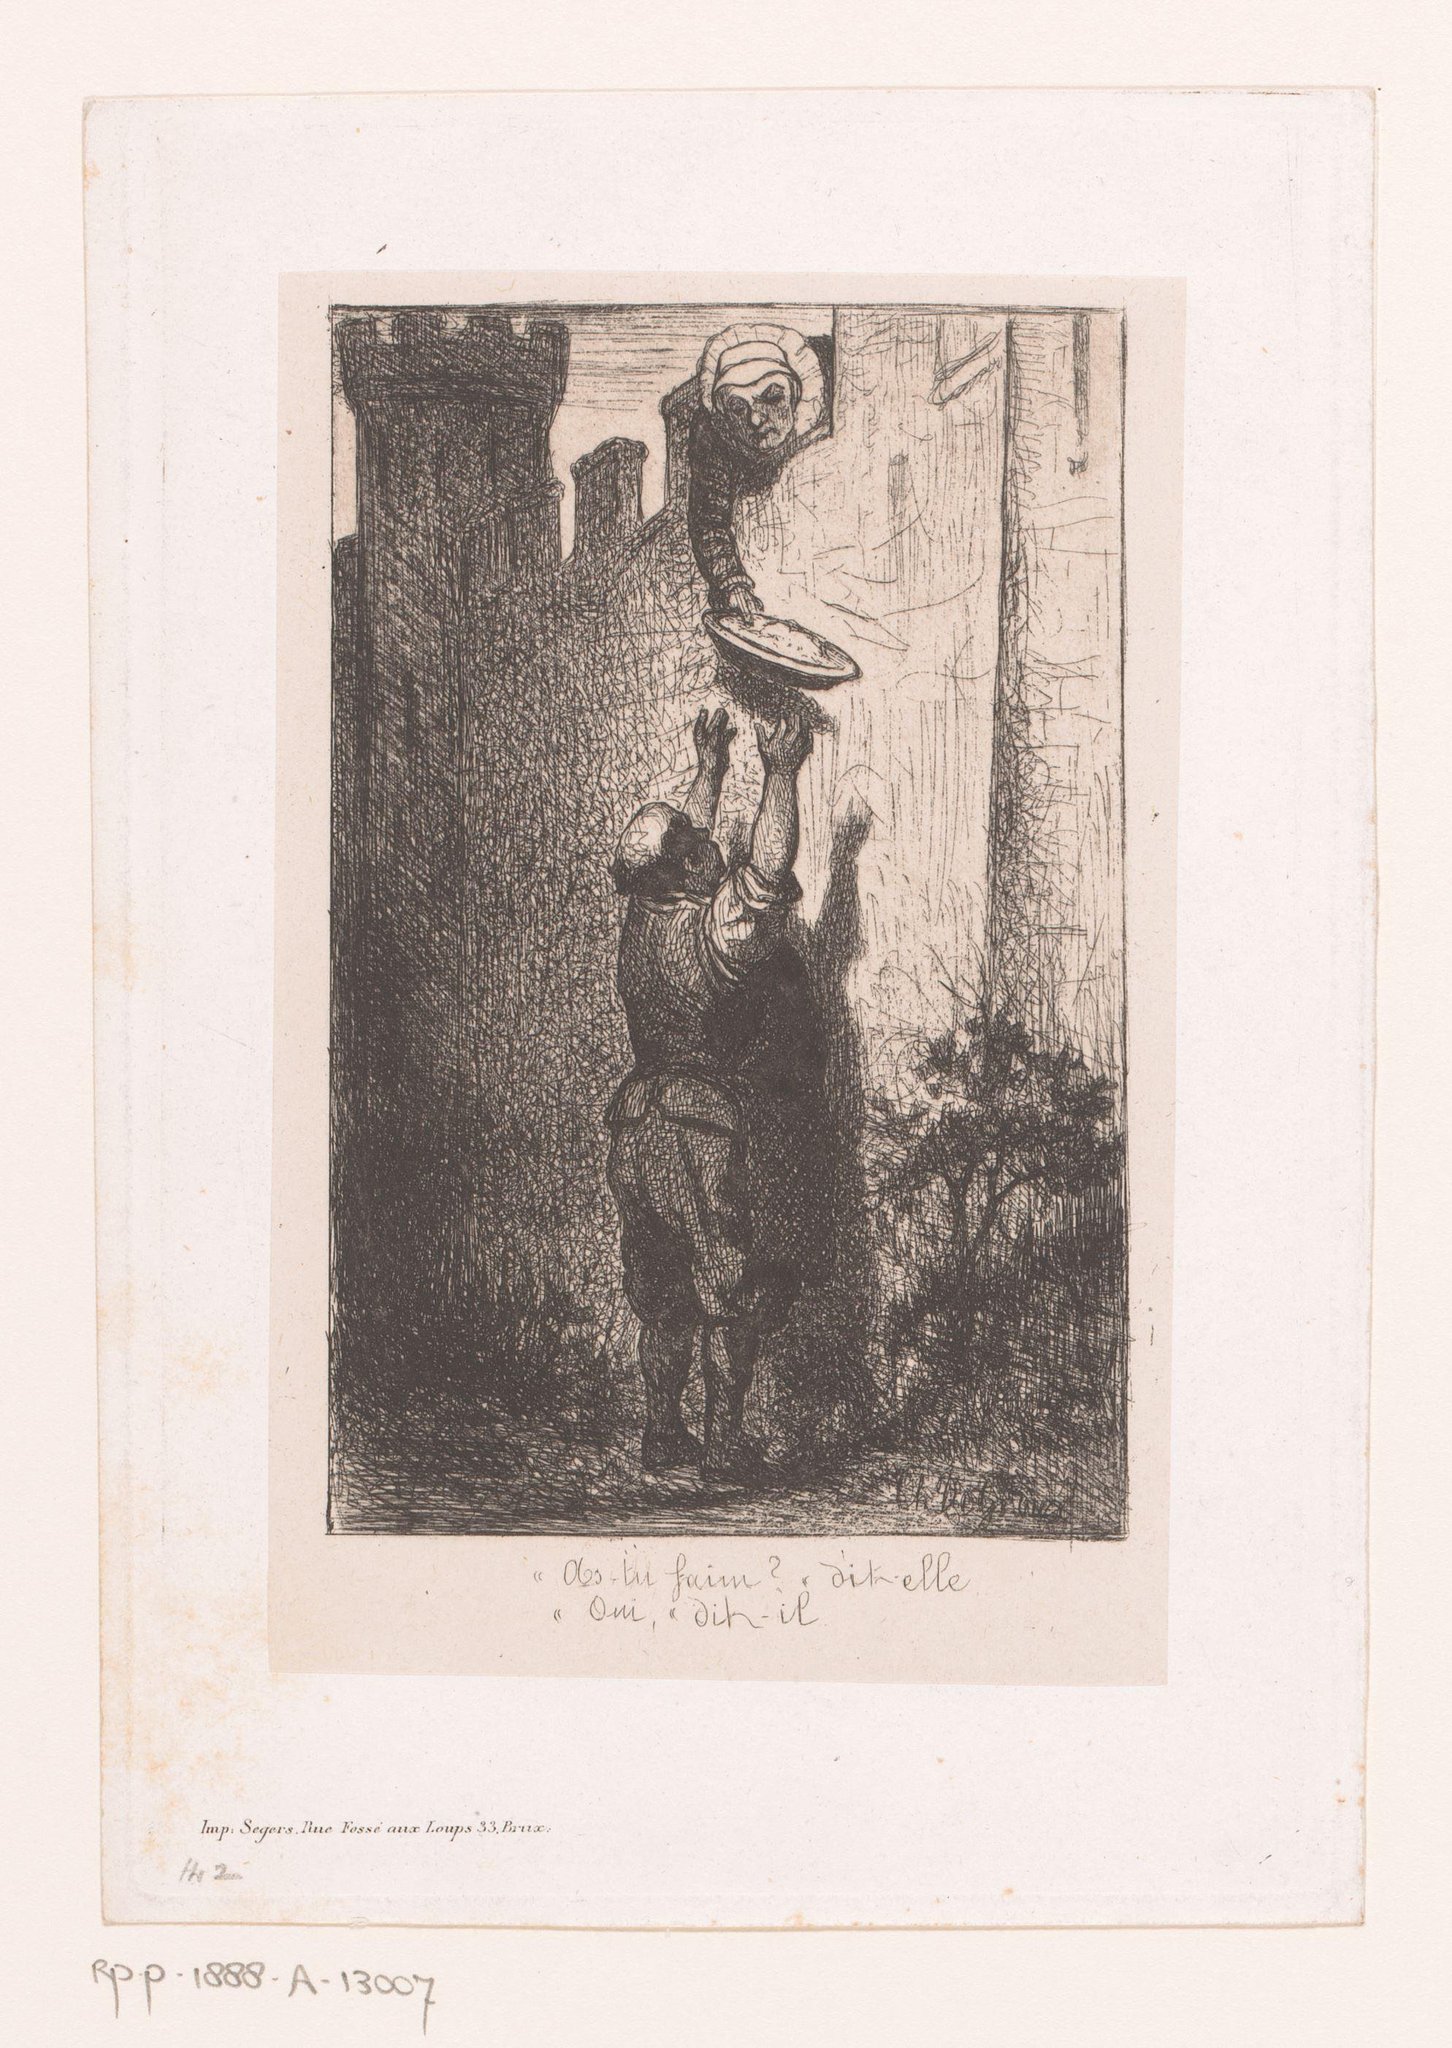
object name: book illustration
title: "As-tu faim?" dit-elle. "Oui," dit-il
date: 1861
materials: paper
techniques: etching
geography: brussels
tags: giving alms or other charity, e.g.: handing out food, battlement, crenellation ~ fortified city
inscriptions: collector's mark: Lugt 2228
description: Latere staat van deze prent gebruikt in: Coster, Charles de. Légendes Flamandes. 1e druk. Brussel: Veuve Parent & Fils, Parijs: Michel-Lévy, Leipzig: Ch. Muquardt, 1861, p. 232-233. De prent illustreert het verhaal Smetse Smee.